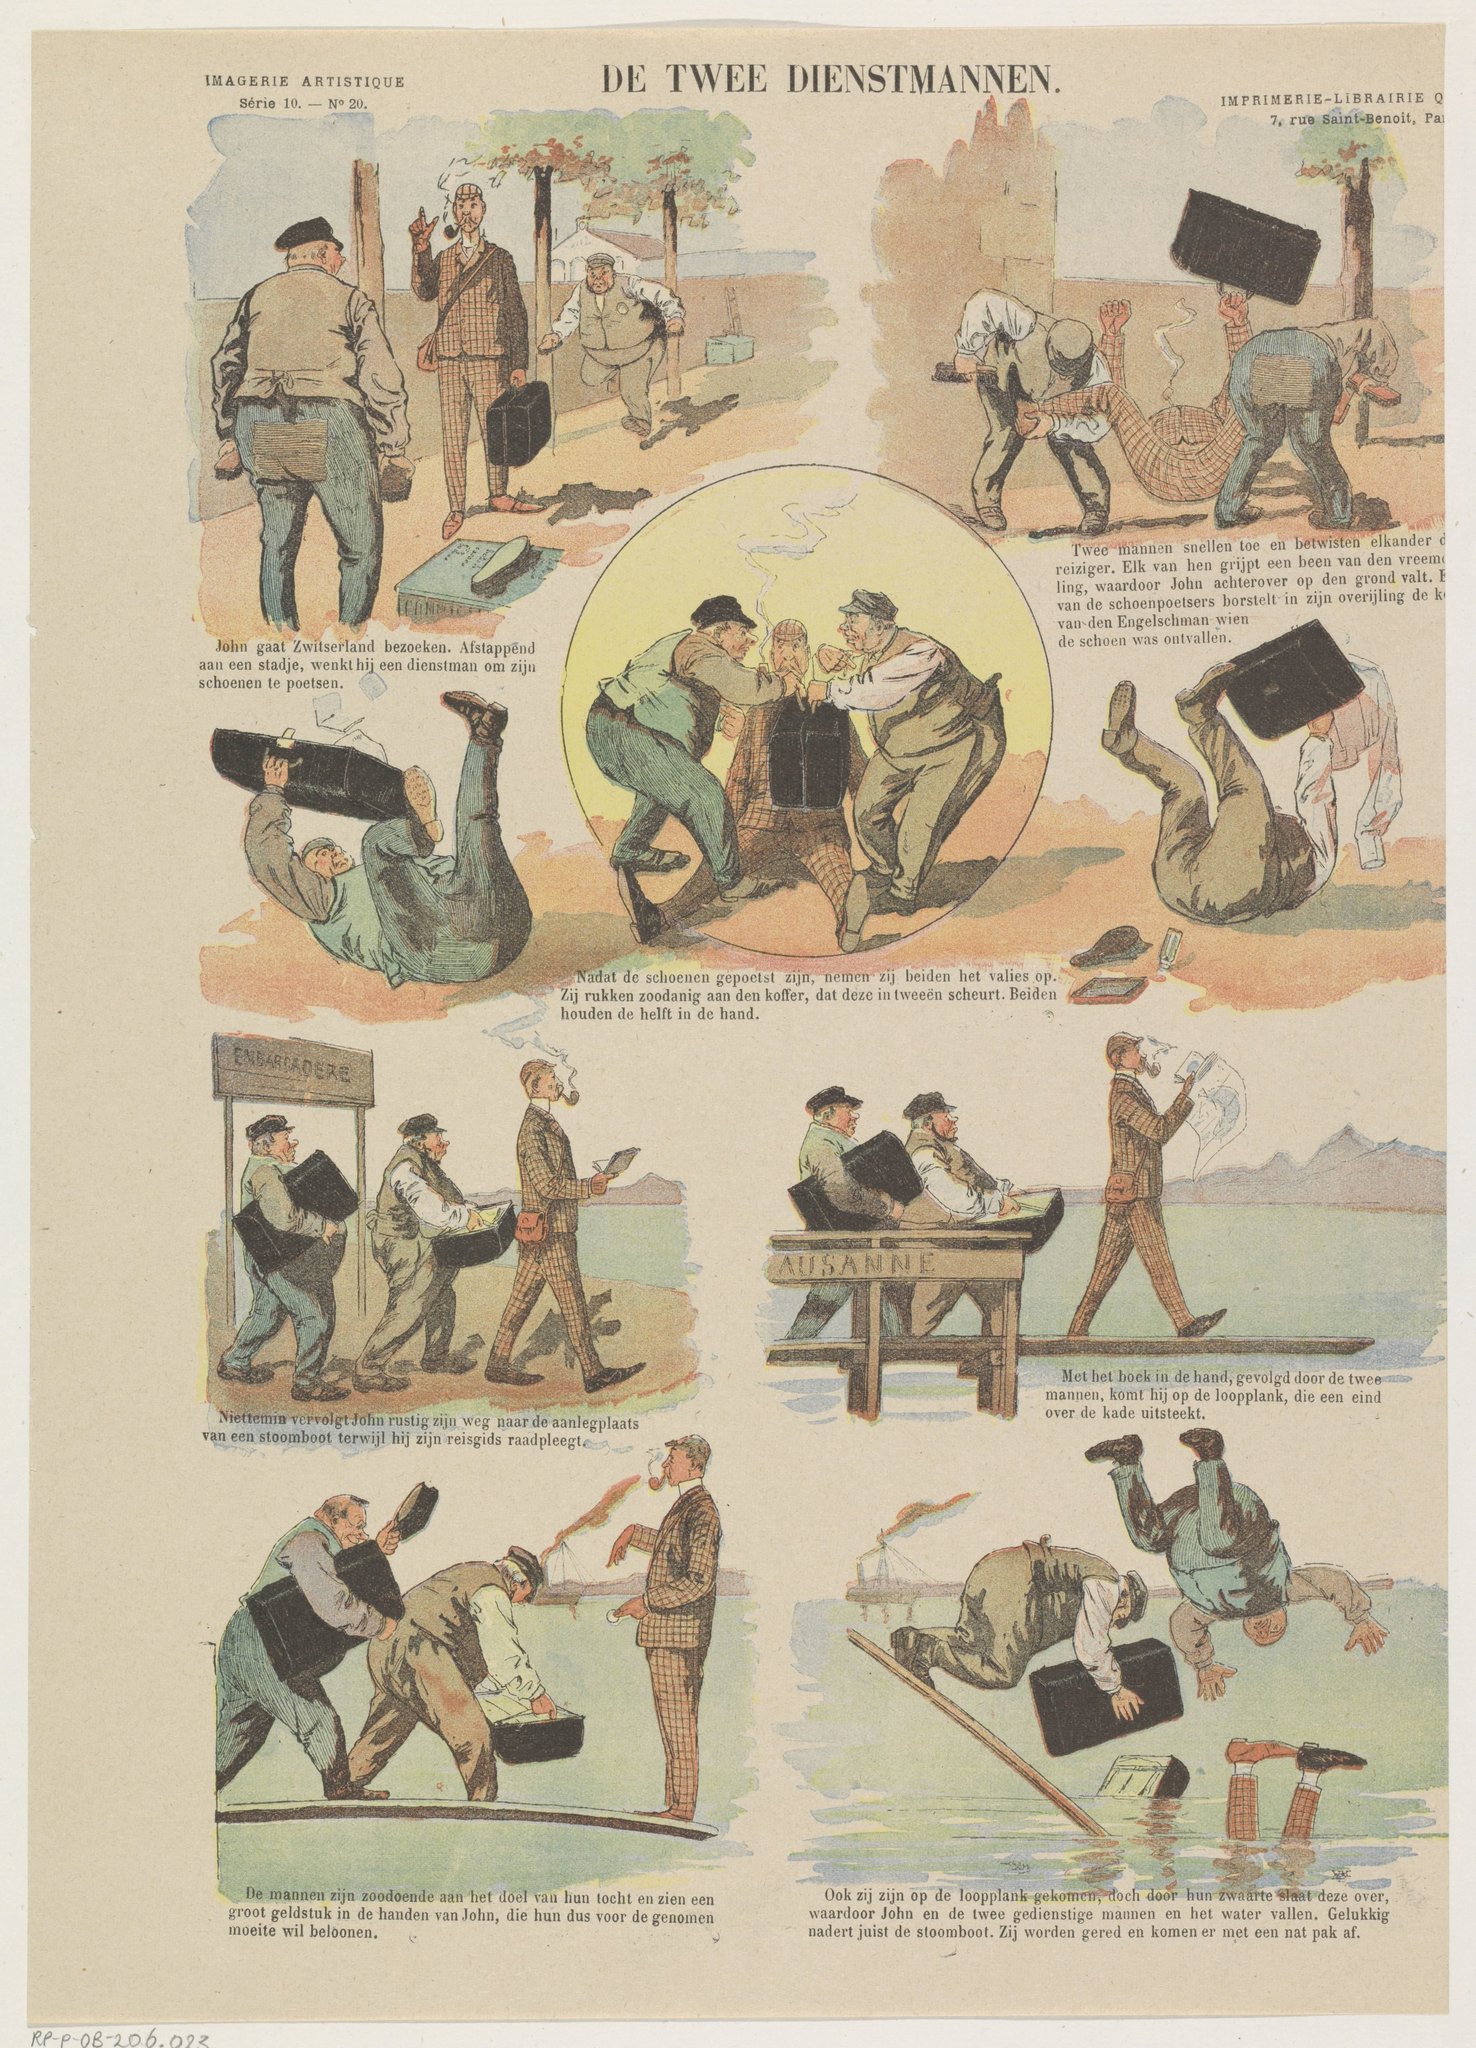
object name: popular print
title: Imagerie Artistique / Série 10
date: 1876-1890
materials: paper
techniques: lithograph, letterpress printing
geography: paris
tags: shoes, sandals, tales and fairy tales, trunk, suit-case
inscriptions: collector's mark: Lugt 2760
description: Blad met 7 voorstellingen van twee overgedienstige schoenpoetsers die vechten om het poetsen van John's schoenen en daarna om het dragen van zijn koffer. Onder elke afbeelding een onderschrift. Genummerd linksboven: Série 10. - No. 20.